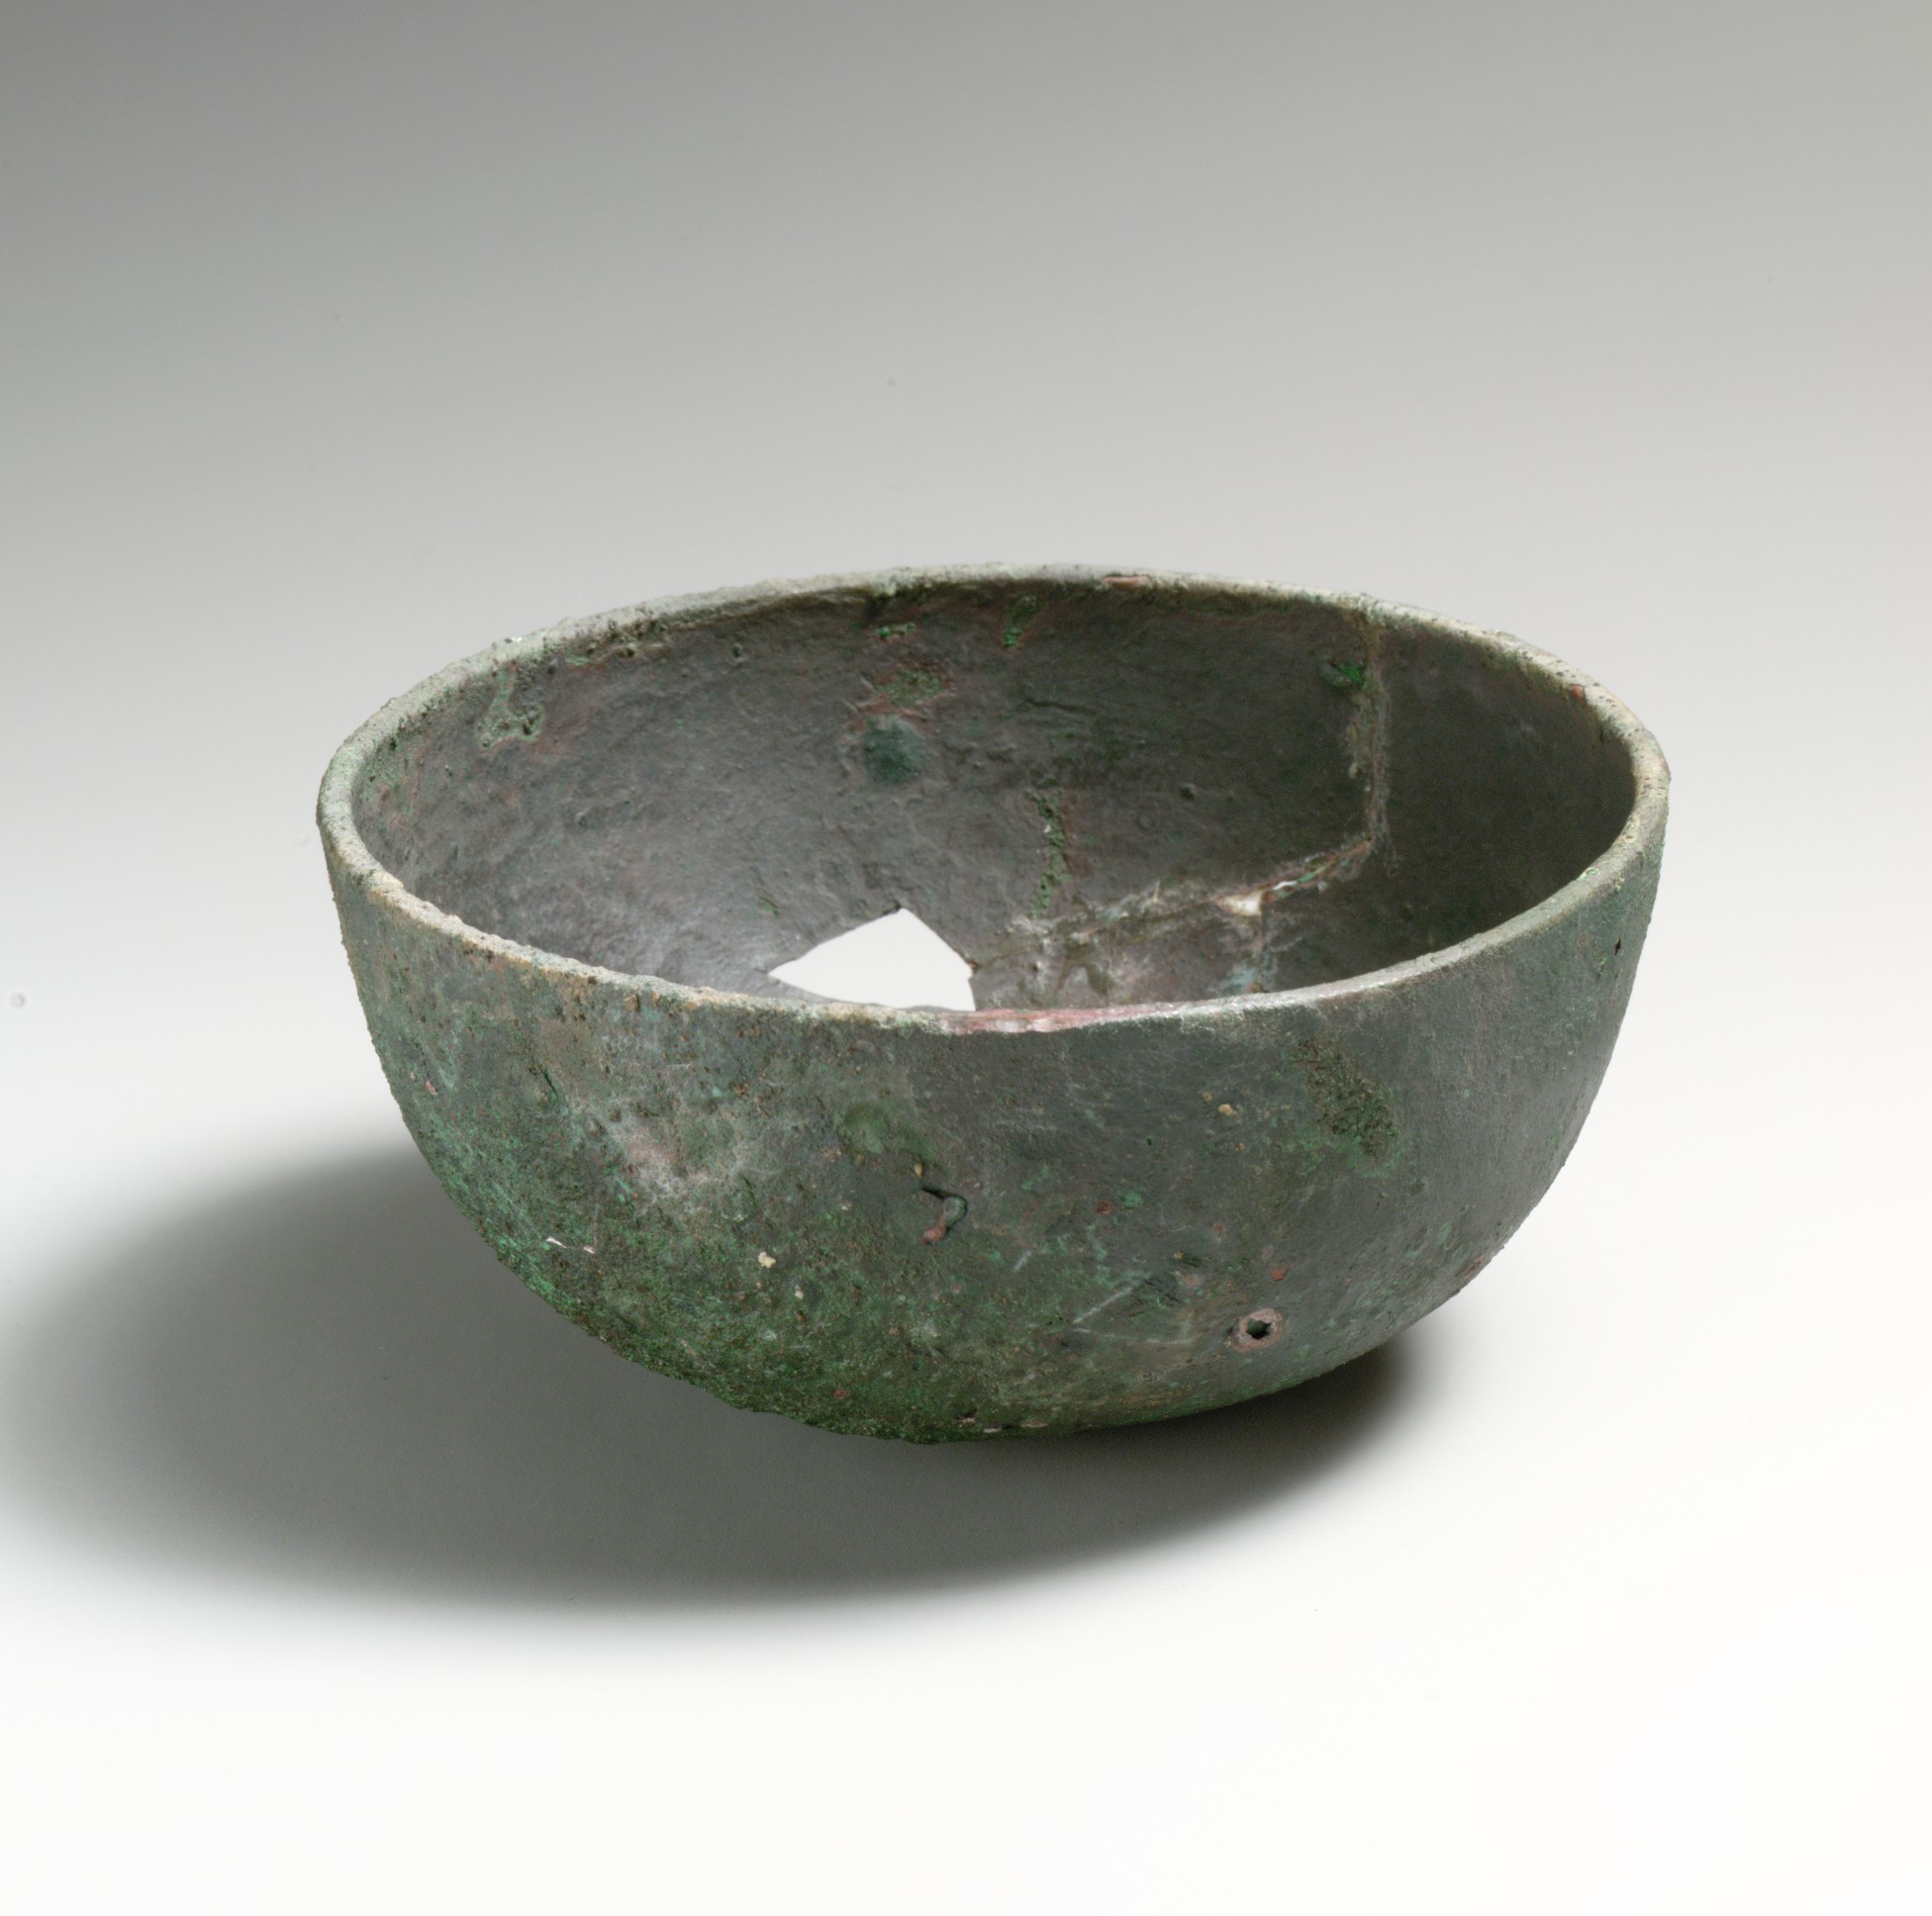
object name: bowl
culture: cypriot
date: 500-401 BCE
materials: bronze